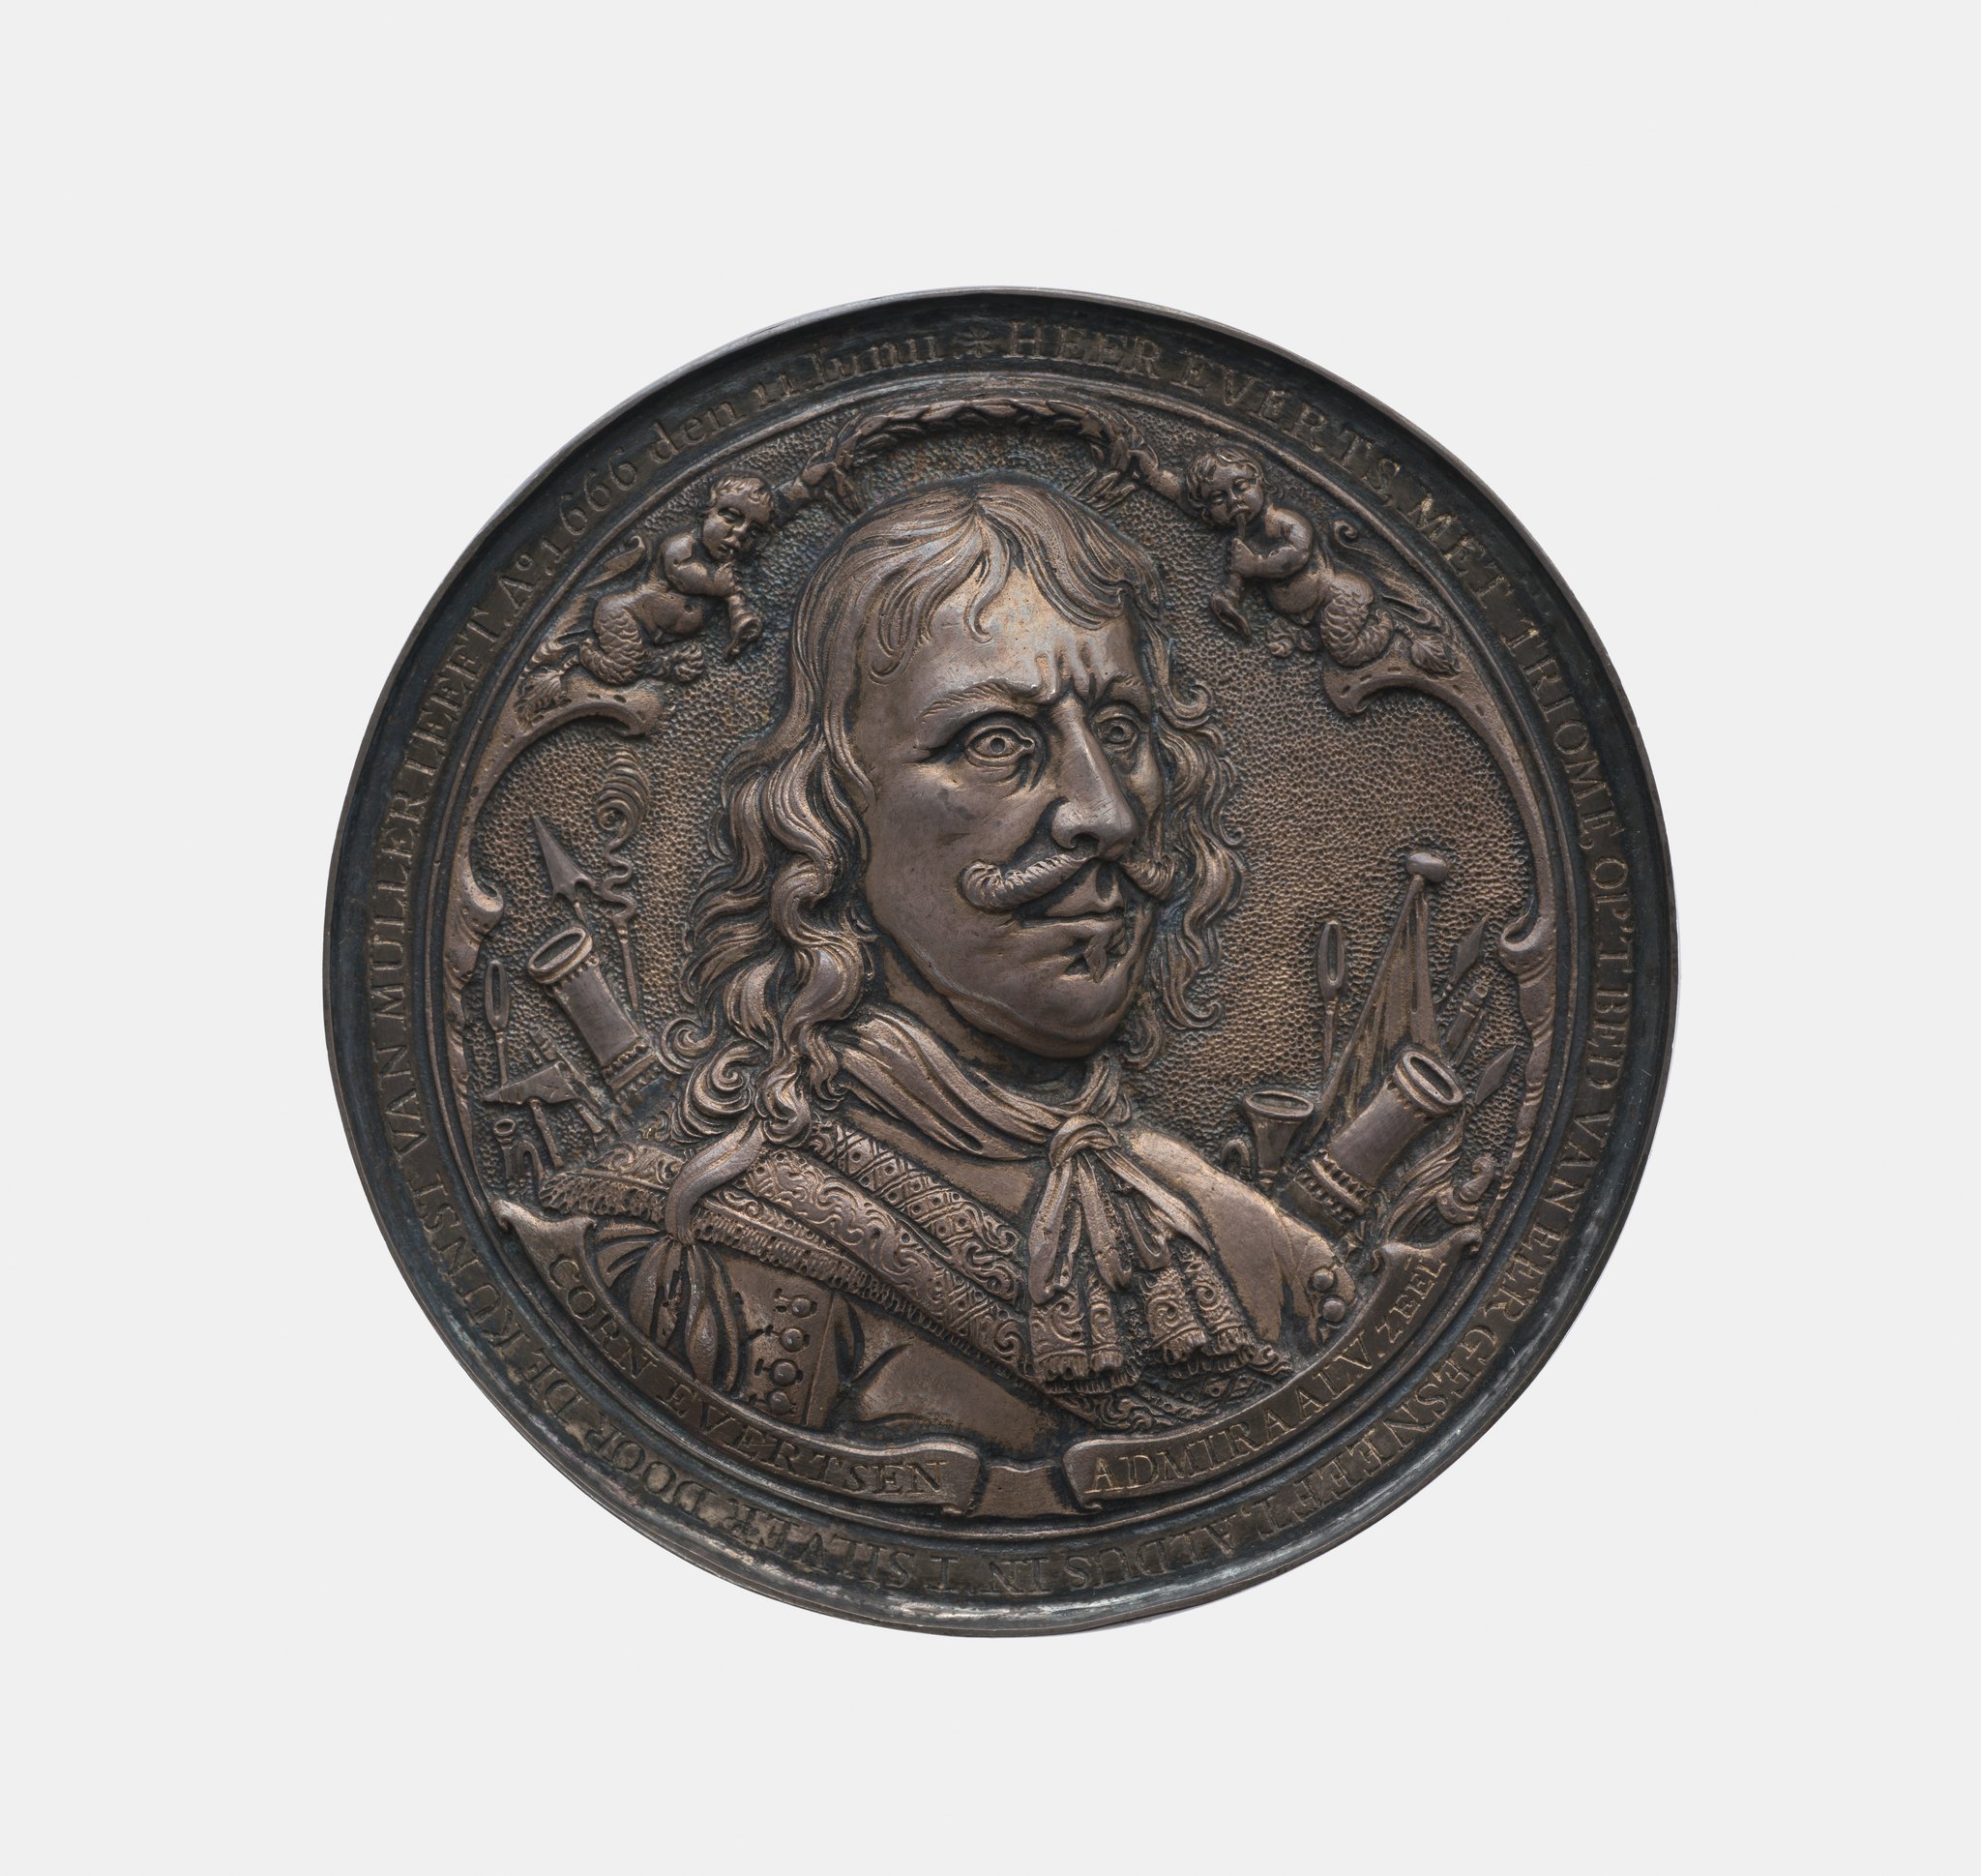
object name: medal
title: Admiral Cornelis Evertsen d. 1666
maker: o. wouter muller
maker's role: artist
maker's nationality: dutch, amsterdam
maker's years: 1653-1688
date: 1666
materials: silver